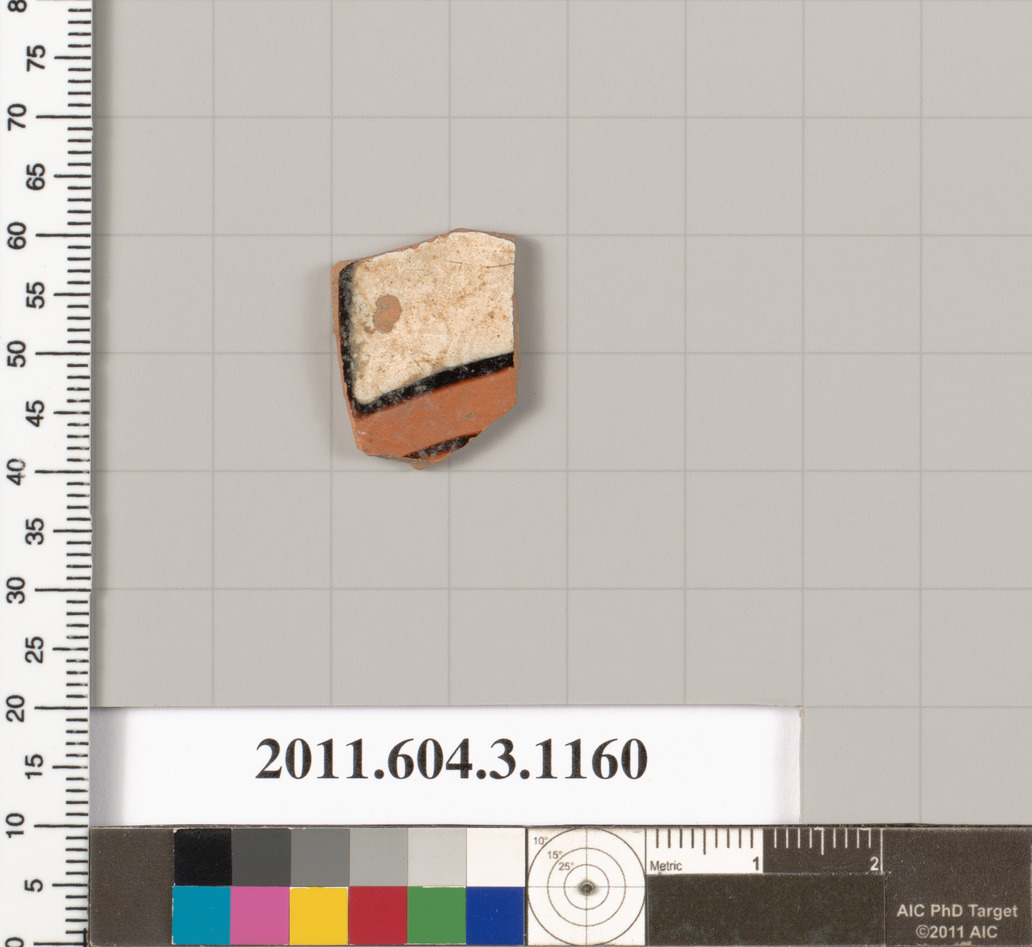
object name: mastoid or kyathos fragment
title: Terracotta fragment of a mastoid (drinking cup with narrow base) or a kyathos (cup-shaped ladle)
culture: greek, attic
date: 534-468 BCE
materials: terracotta